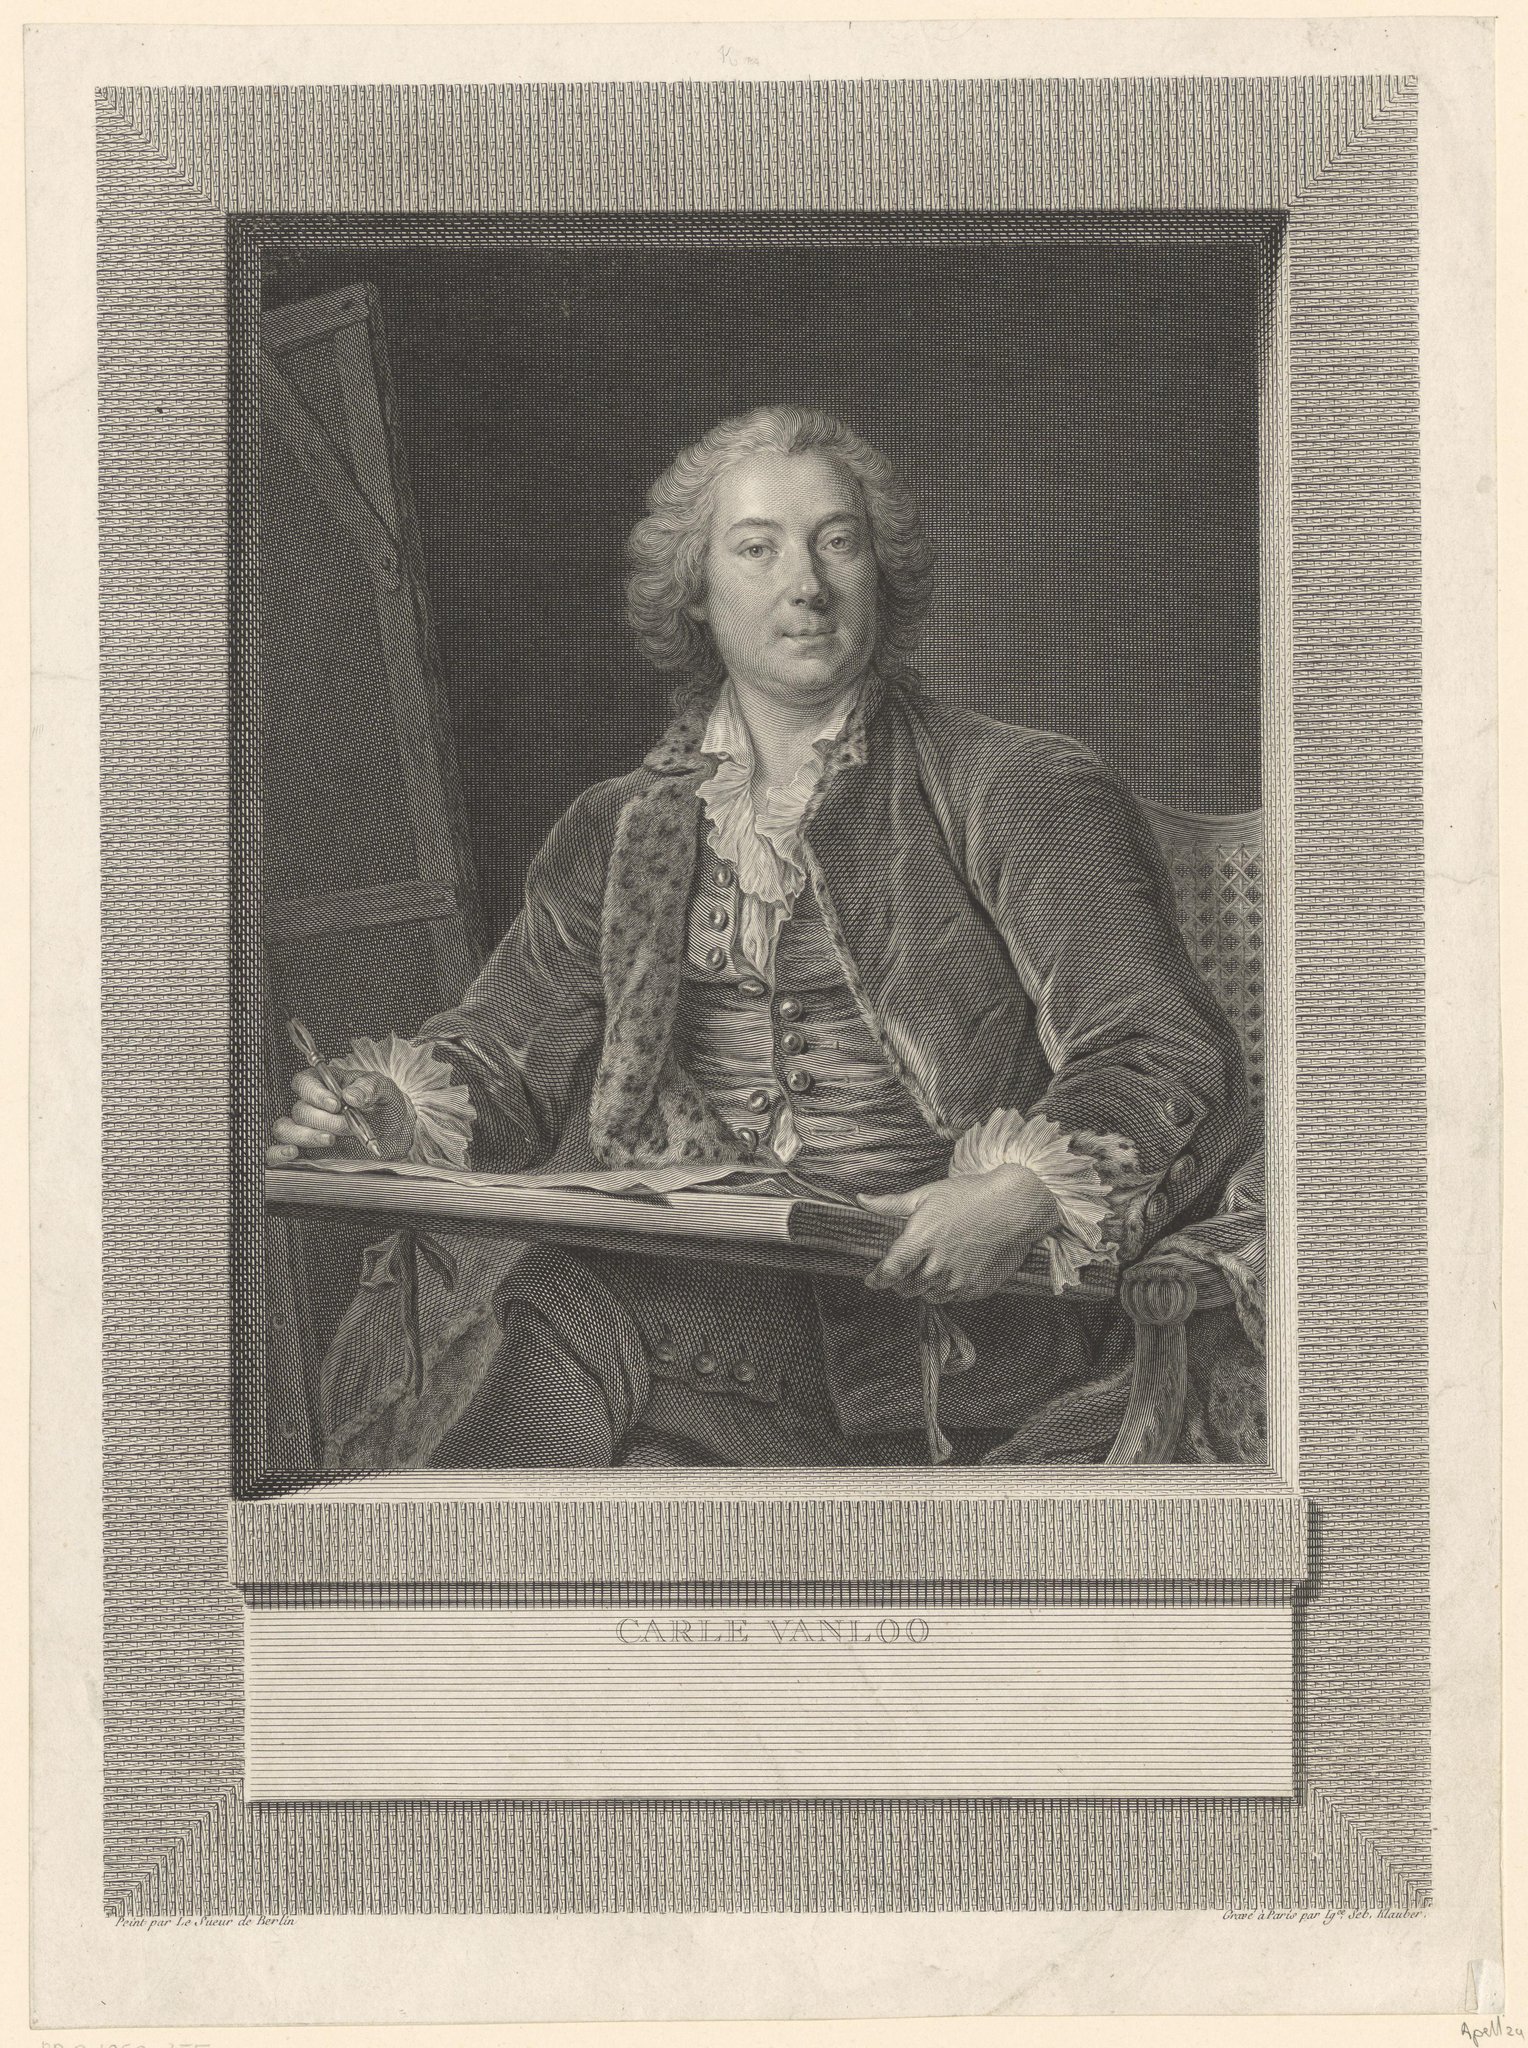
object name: print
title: Portret van Carle van Loo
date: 1785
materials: paper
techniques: engraving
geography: paris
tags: painter, print maker, carle van loo, historical persons, portrait, self-portrait of painter, portrait, self-portrait of graphic artist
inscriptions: collector's mark: Lugt 2228